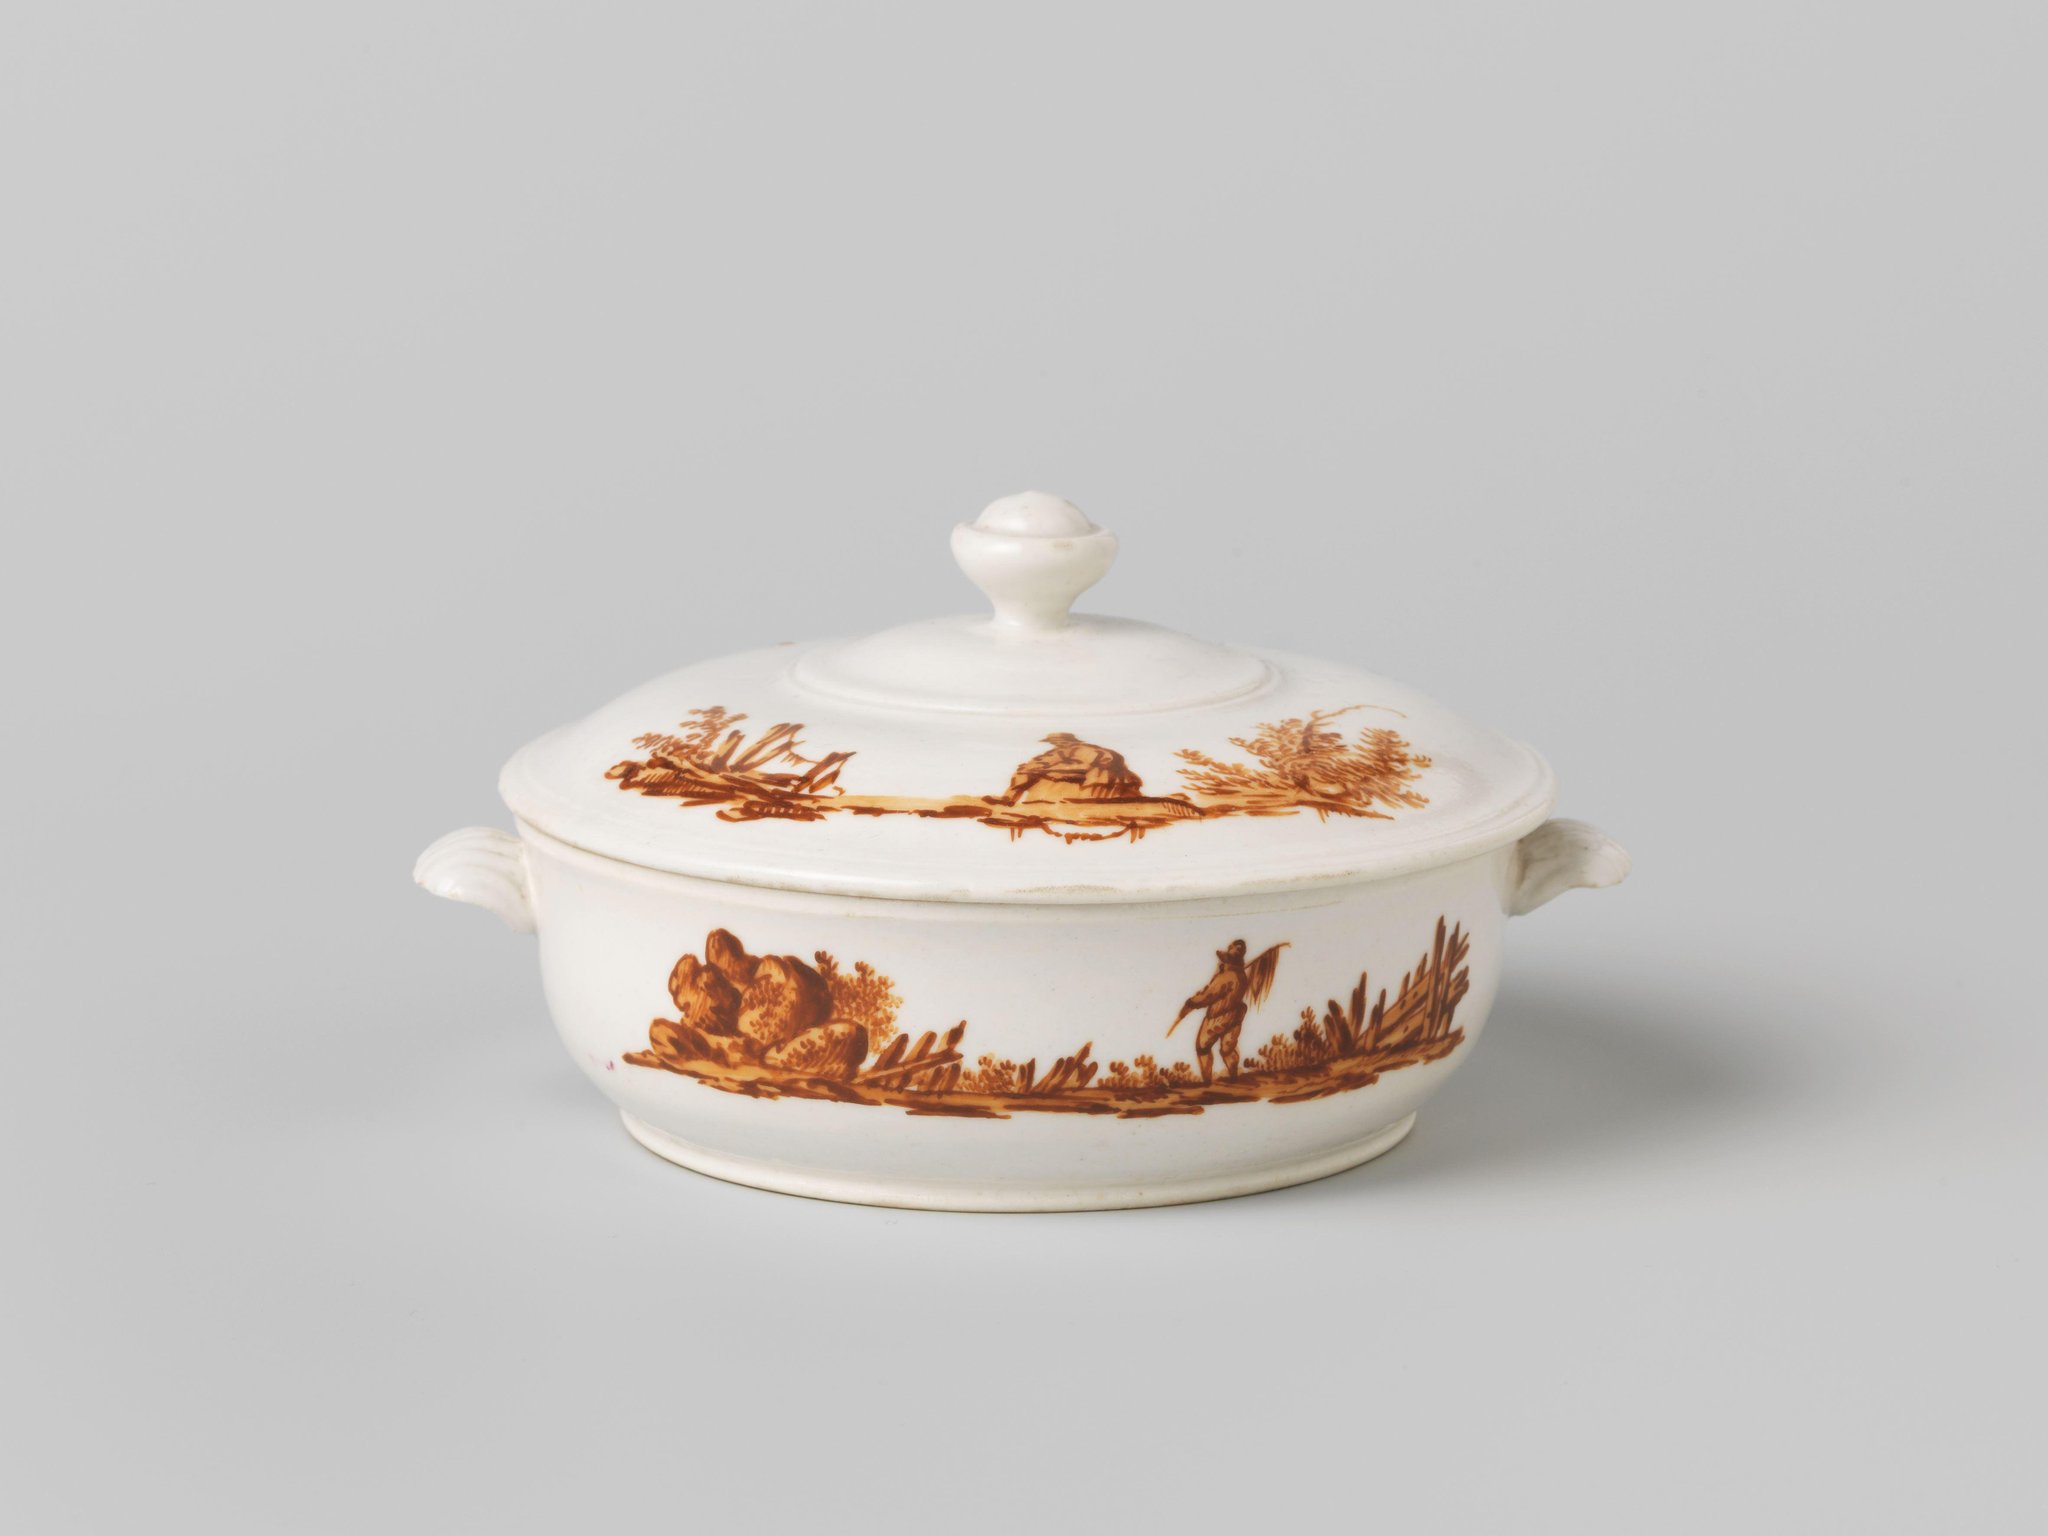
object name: butter dish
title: Botervloot, beschilderd met landschappen met figuren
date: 1774-1778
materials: porcelain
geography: loosdrecht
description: Botervloot van porselein. Licht gewelfde gladde wand en deksel.De oren in de vorm van schelpen. Aan beide zijden van de vloot en twee maal op de deksels een landschapsgrondje in sepia zonder, met één of met twee figuren.